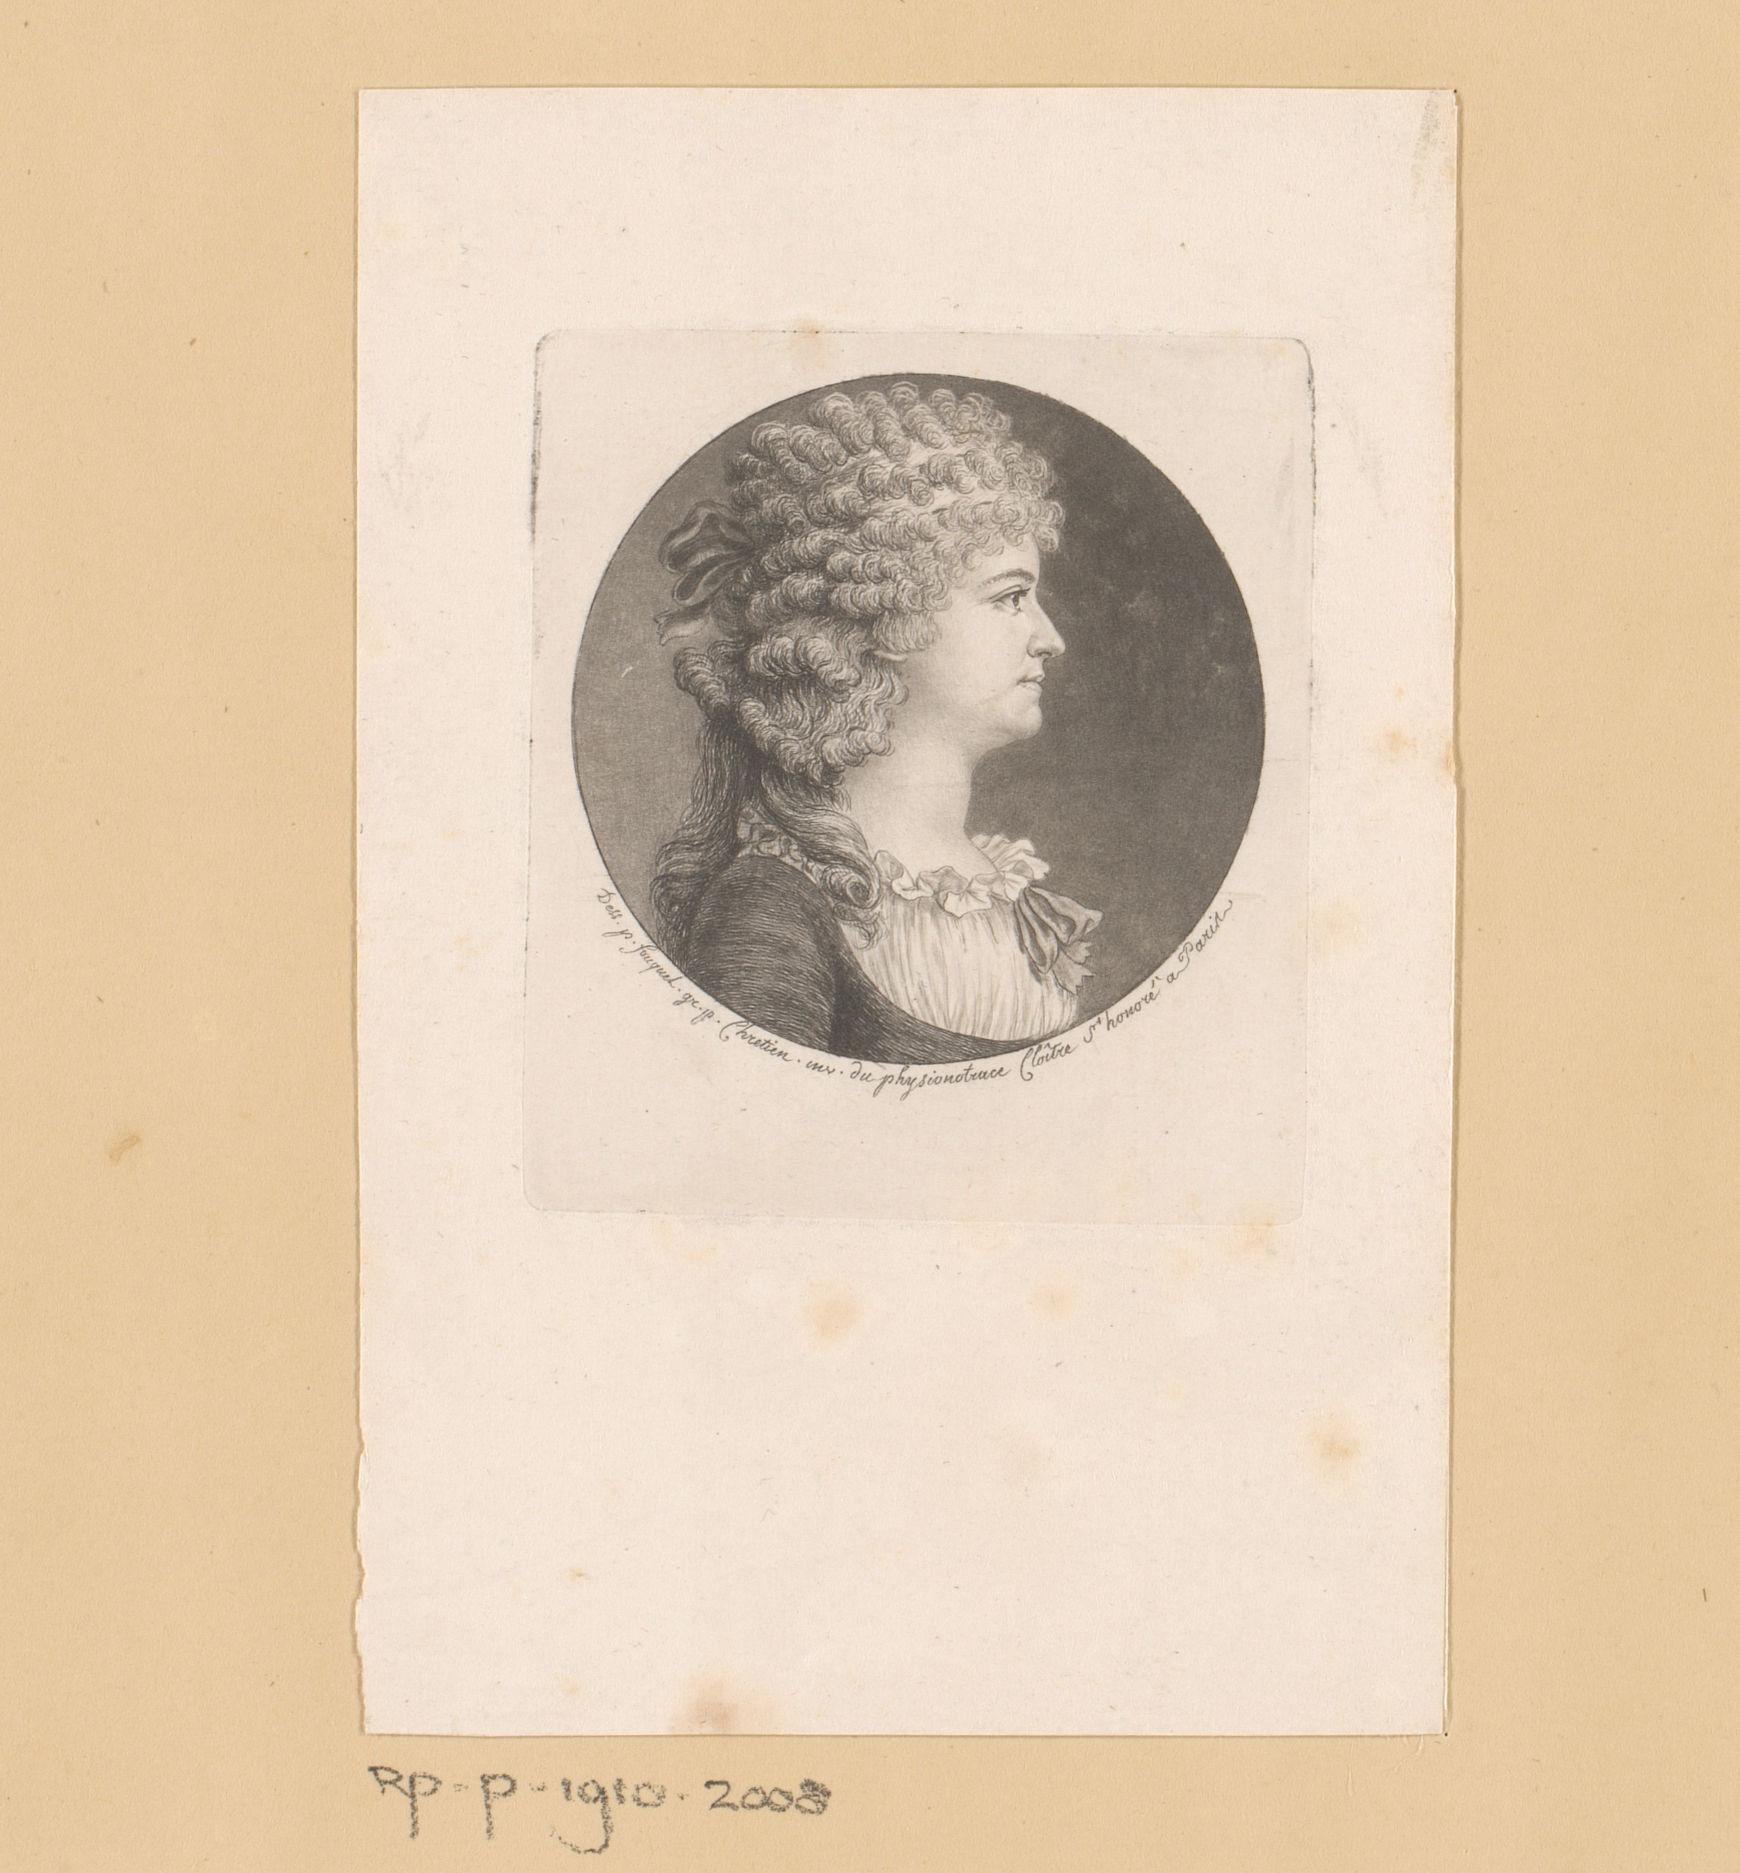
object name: physionotrace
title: Portret van Petronella Helena Clasina van der Capellen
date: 1785-1811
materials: paper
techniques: aquatint, etching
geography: paris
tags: silhouette-apparatus, 'physionotrace', historical persons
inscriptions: collector's mark: Lugt 2228